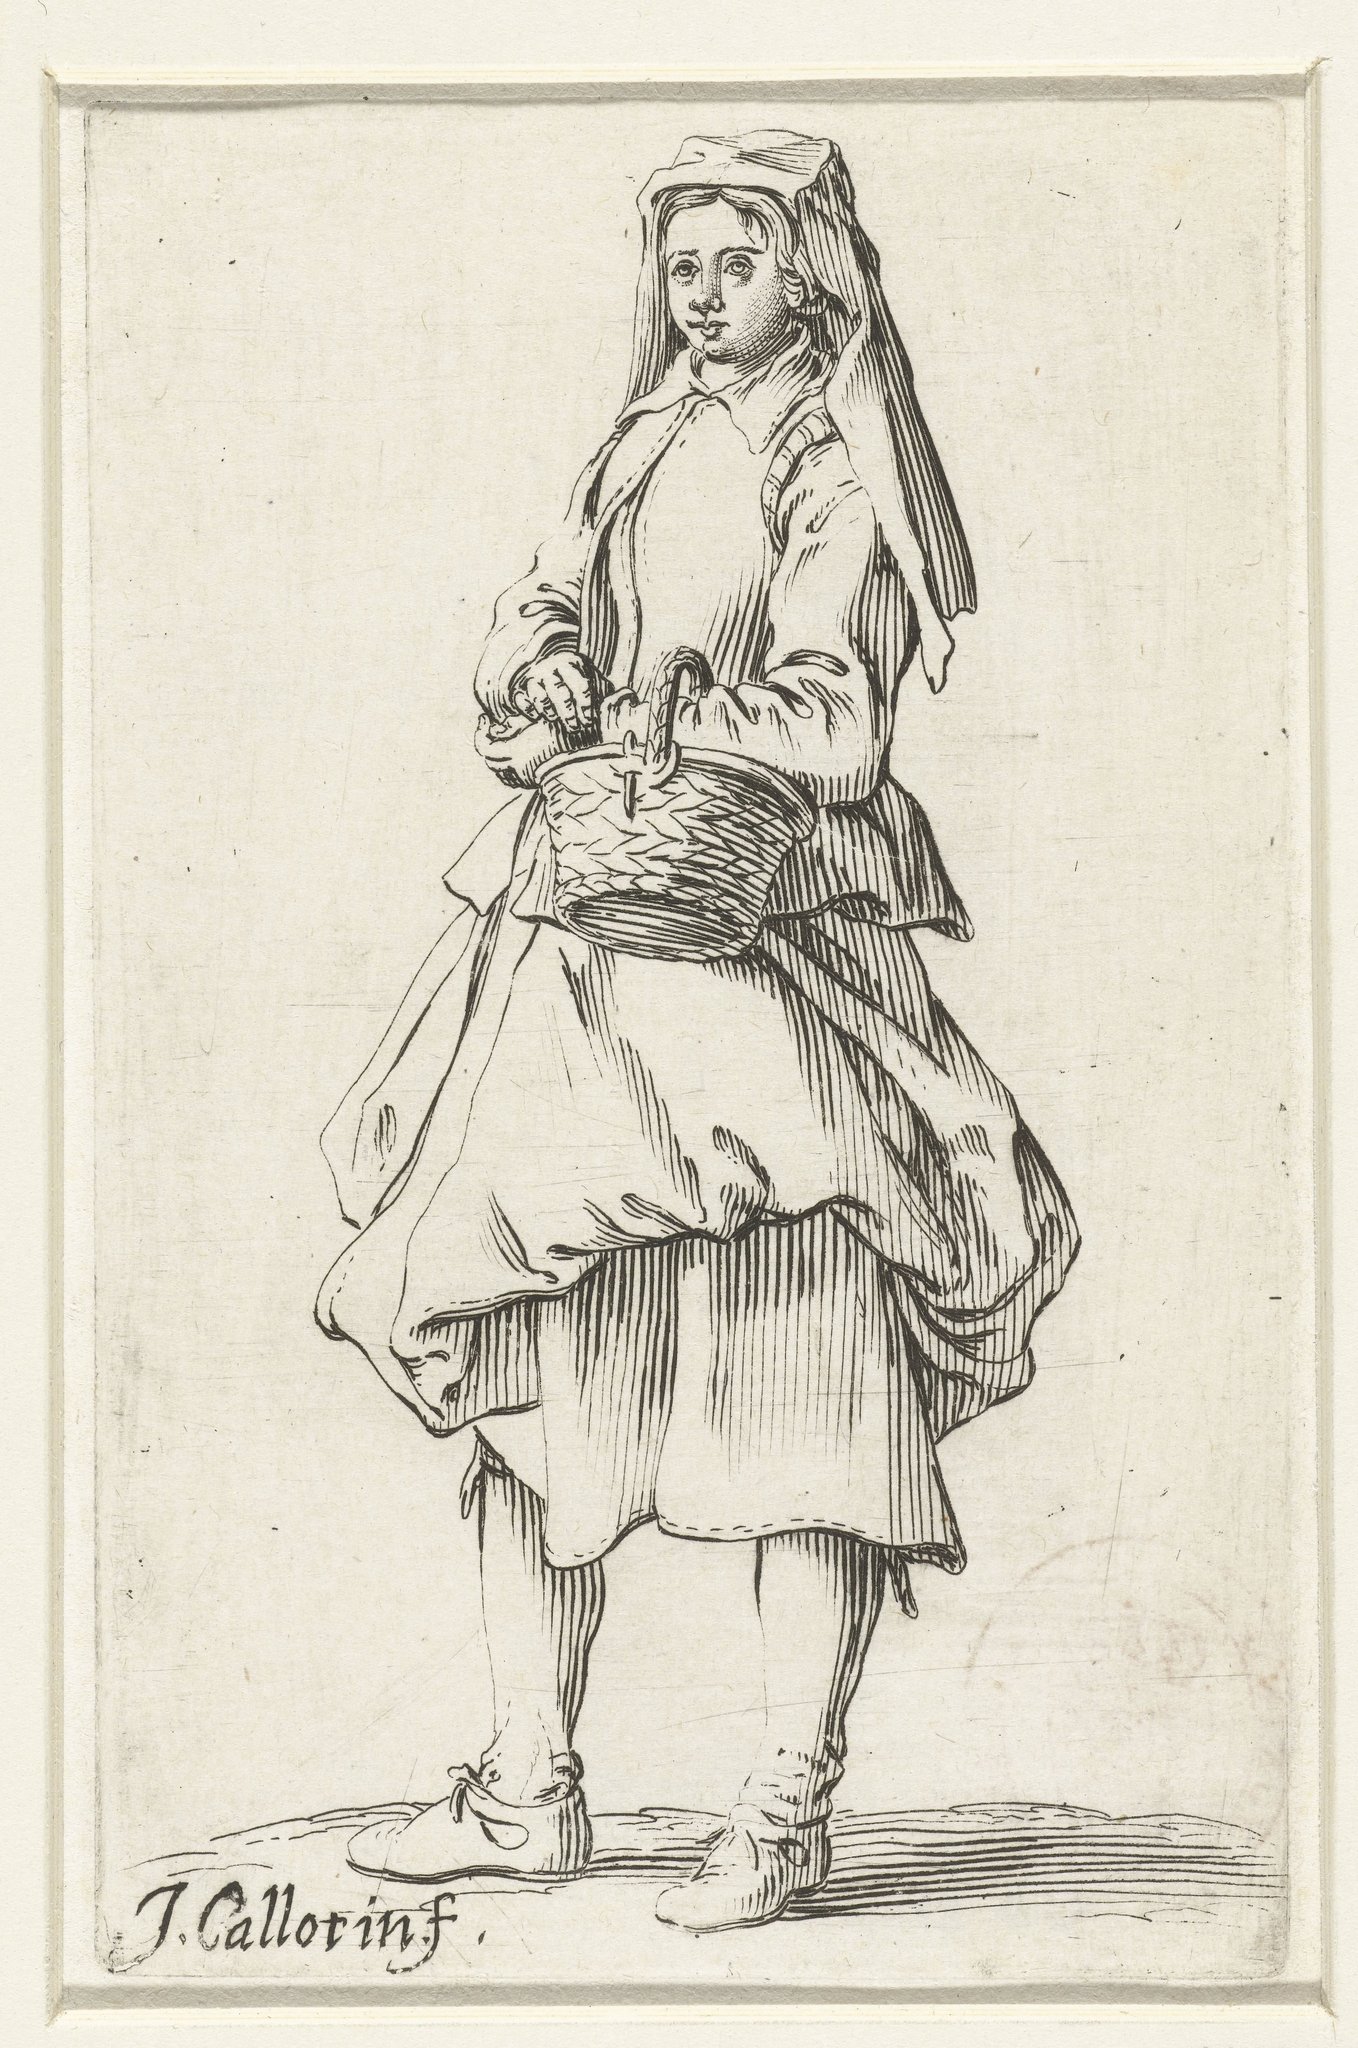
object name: costume print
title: Vier vrouwen in verschillende kostuums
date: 1630-1661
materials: paper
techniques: etching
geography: paris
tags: container made of plant material other than wood: basket, dress, gown (+ women's clothes), veil, france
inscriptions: collector's mark: Lugt 240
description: Vrouw, ten voeten uit, op de linkerzijde gezien, een mand aan de arm, gehuld in Franse landelijke kleding zoals die gedragen werd rond 1625.